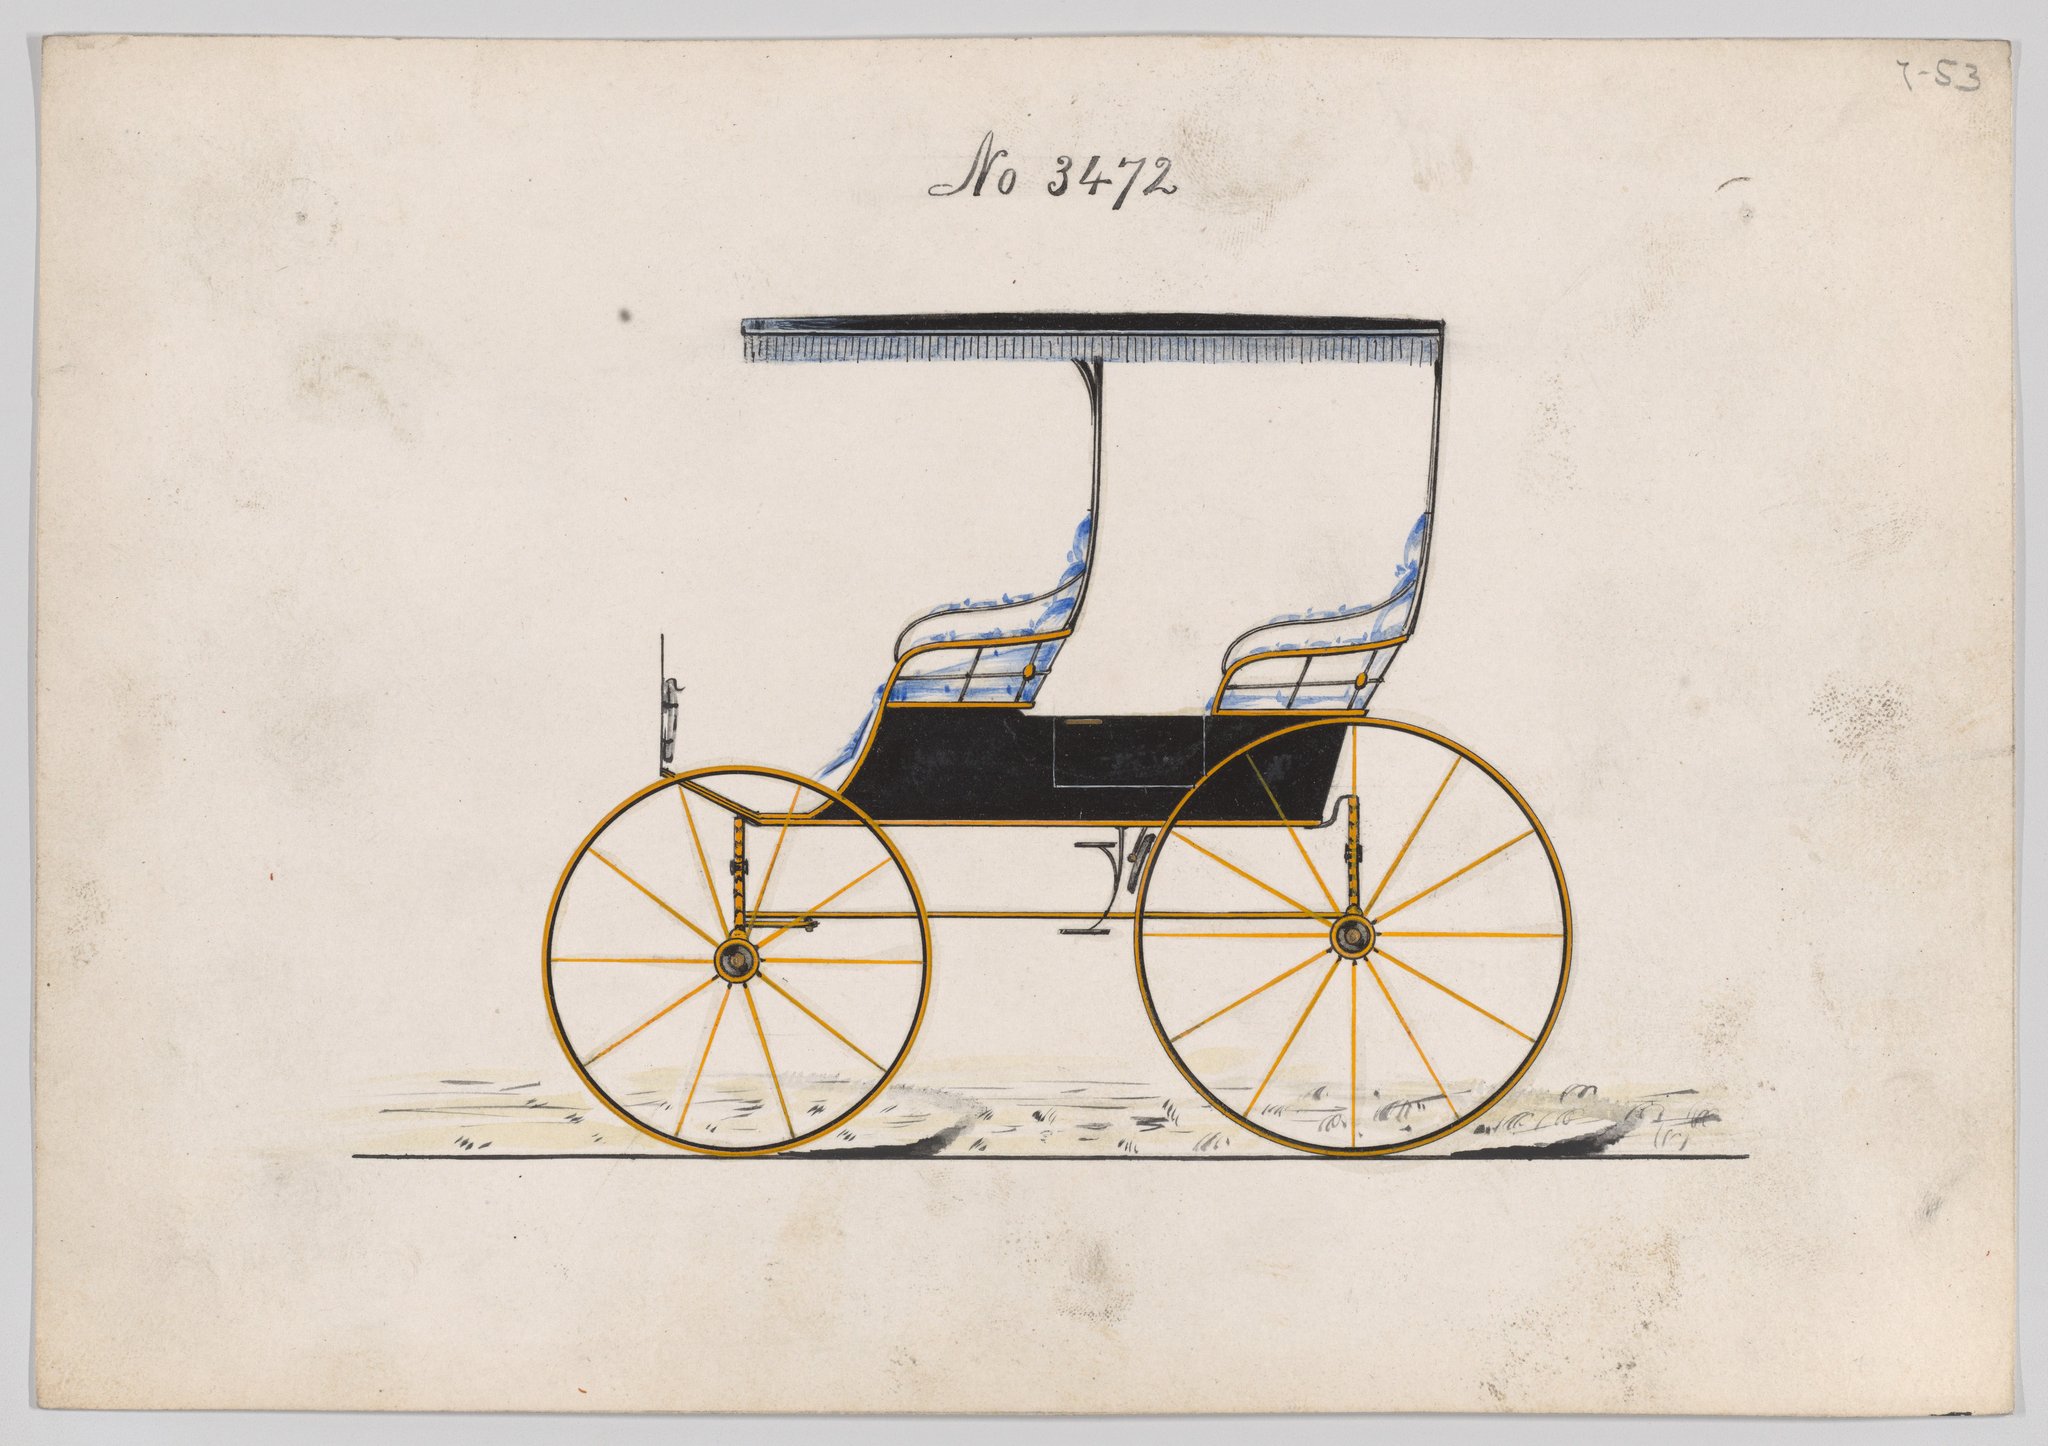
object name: drawing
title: Design for Canopy Top Phaeton, no. 3472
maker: brewster & co.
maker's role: manufacturer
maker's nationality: american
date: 1878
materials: gouache, gum arabic, ink, watercolor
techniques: pen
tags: carriages